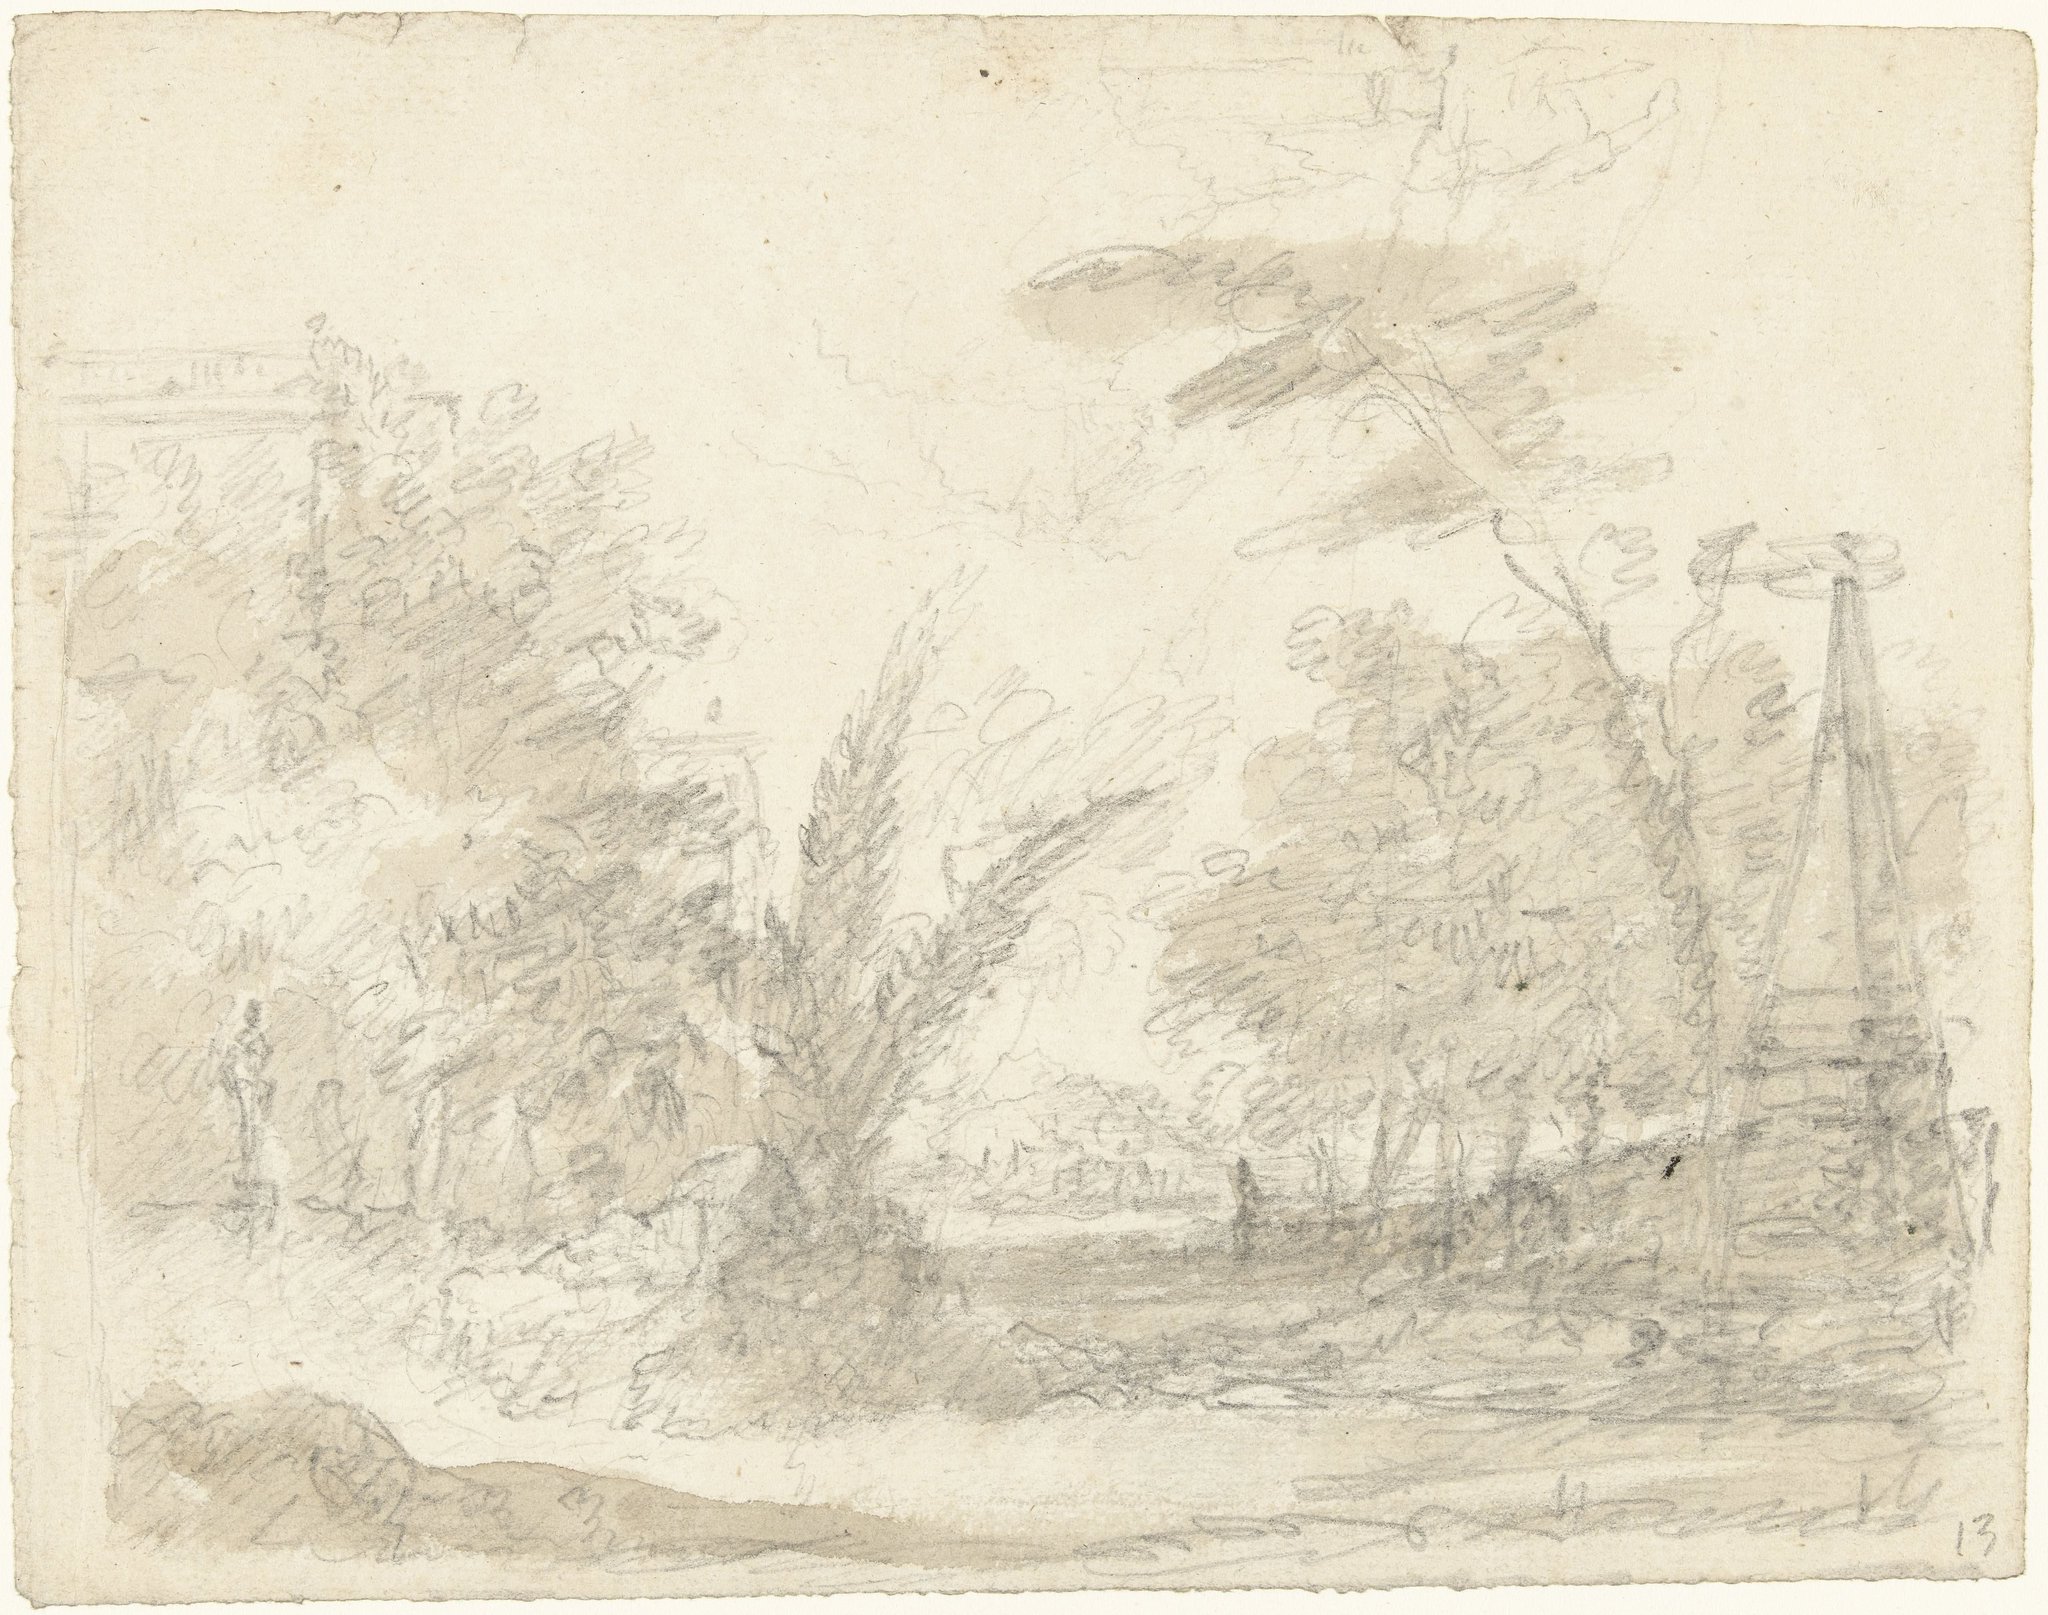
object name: drawing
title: Tuin met een obelisk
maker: dionys van nijmegen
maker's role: draughtsman, painter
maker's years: 1705-1798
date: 1715-1798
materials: paper, pencil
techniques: brush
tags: garden